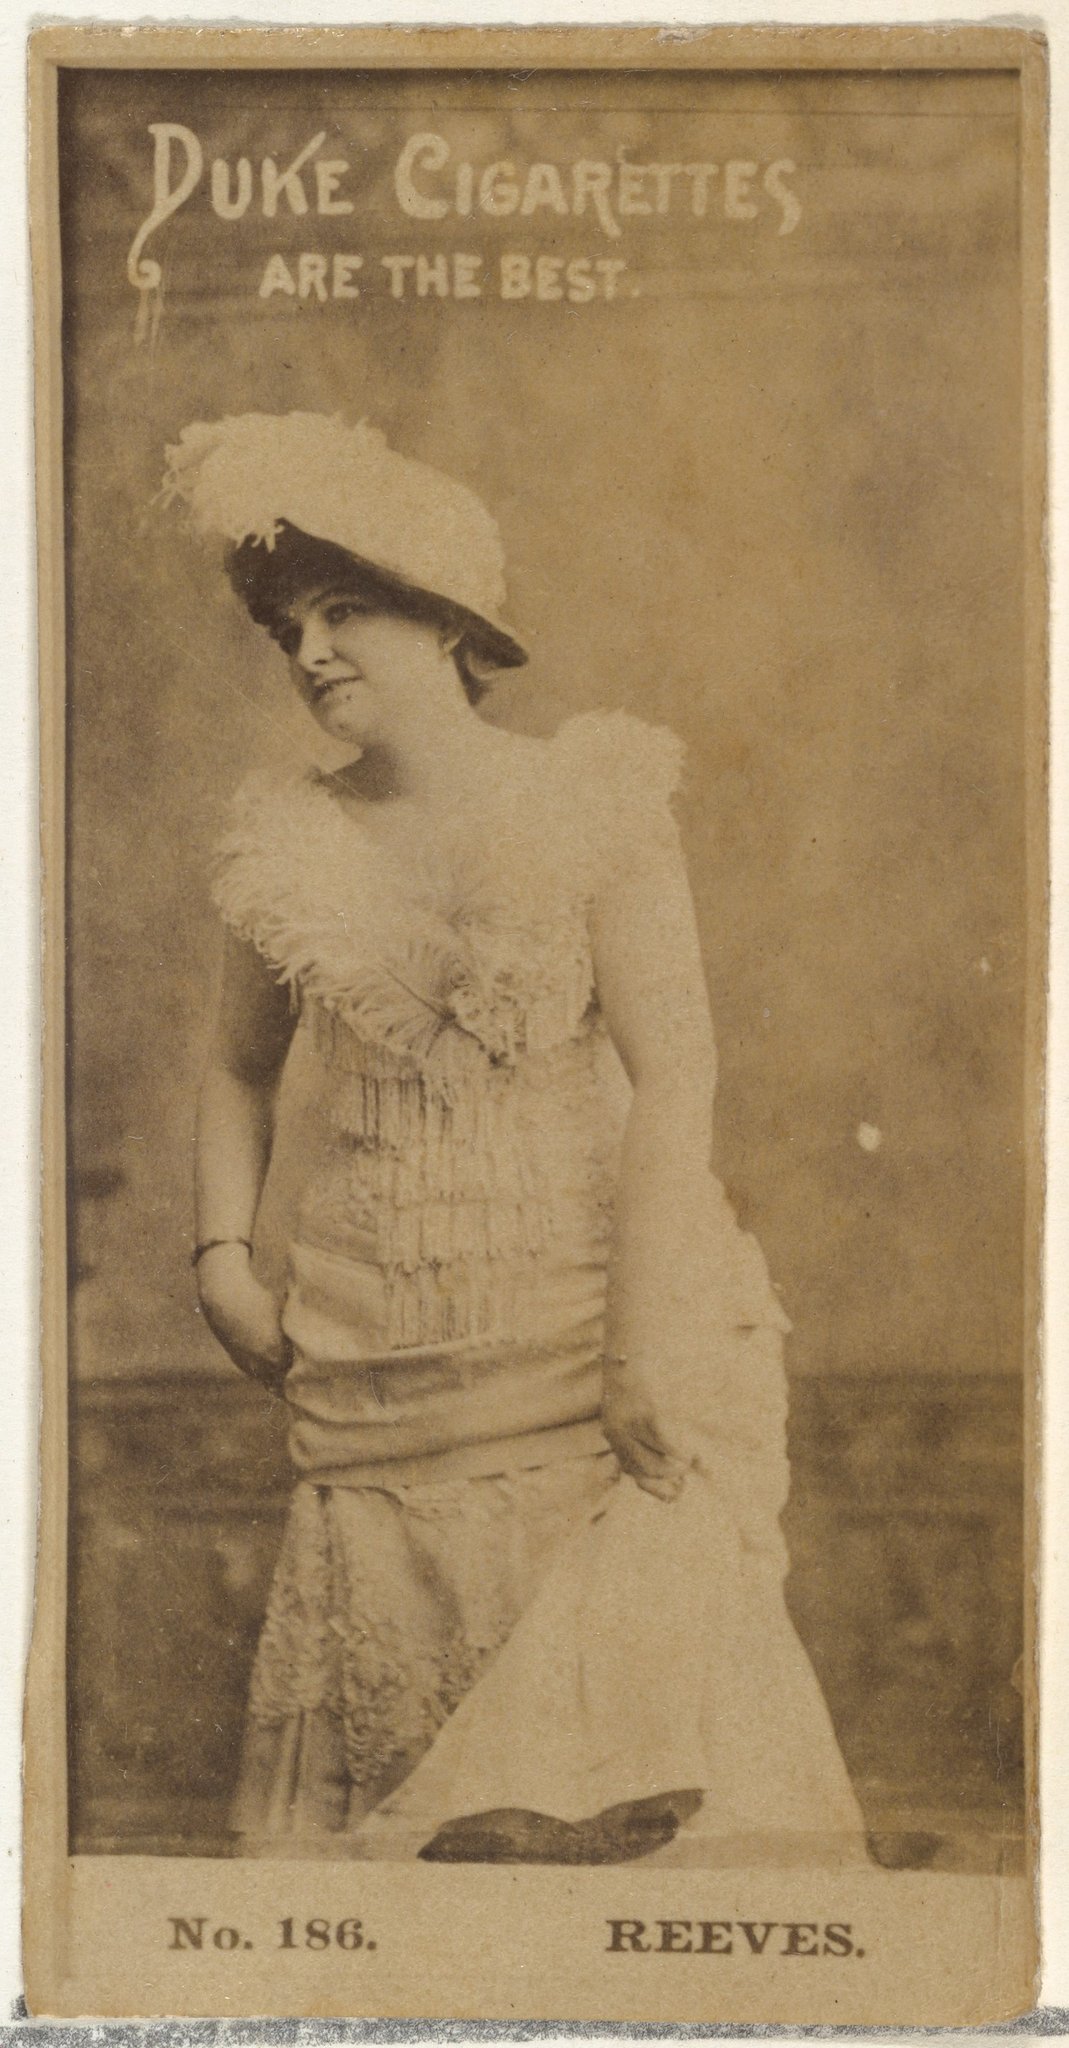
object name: photograph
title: Card Number 186, Miss Reeves, from the Actors and Actresses series (N145-6) issued by Duke Sons & Co. to promote Duke Cigarettes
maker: w. duke, sons & co.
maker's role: publisher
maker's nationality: american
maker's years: 1870-1920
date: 1880-1889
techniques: albumen silver print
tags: portraits,women,actresses